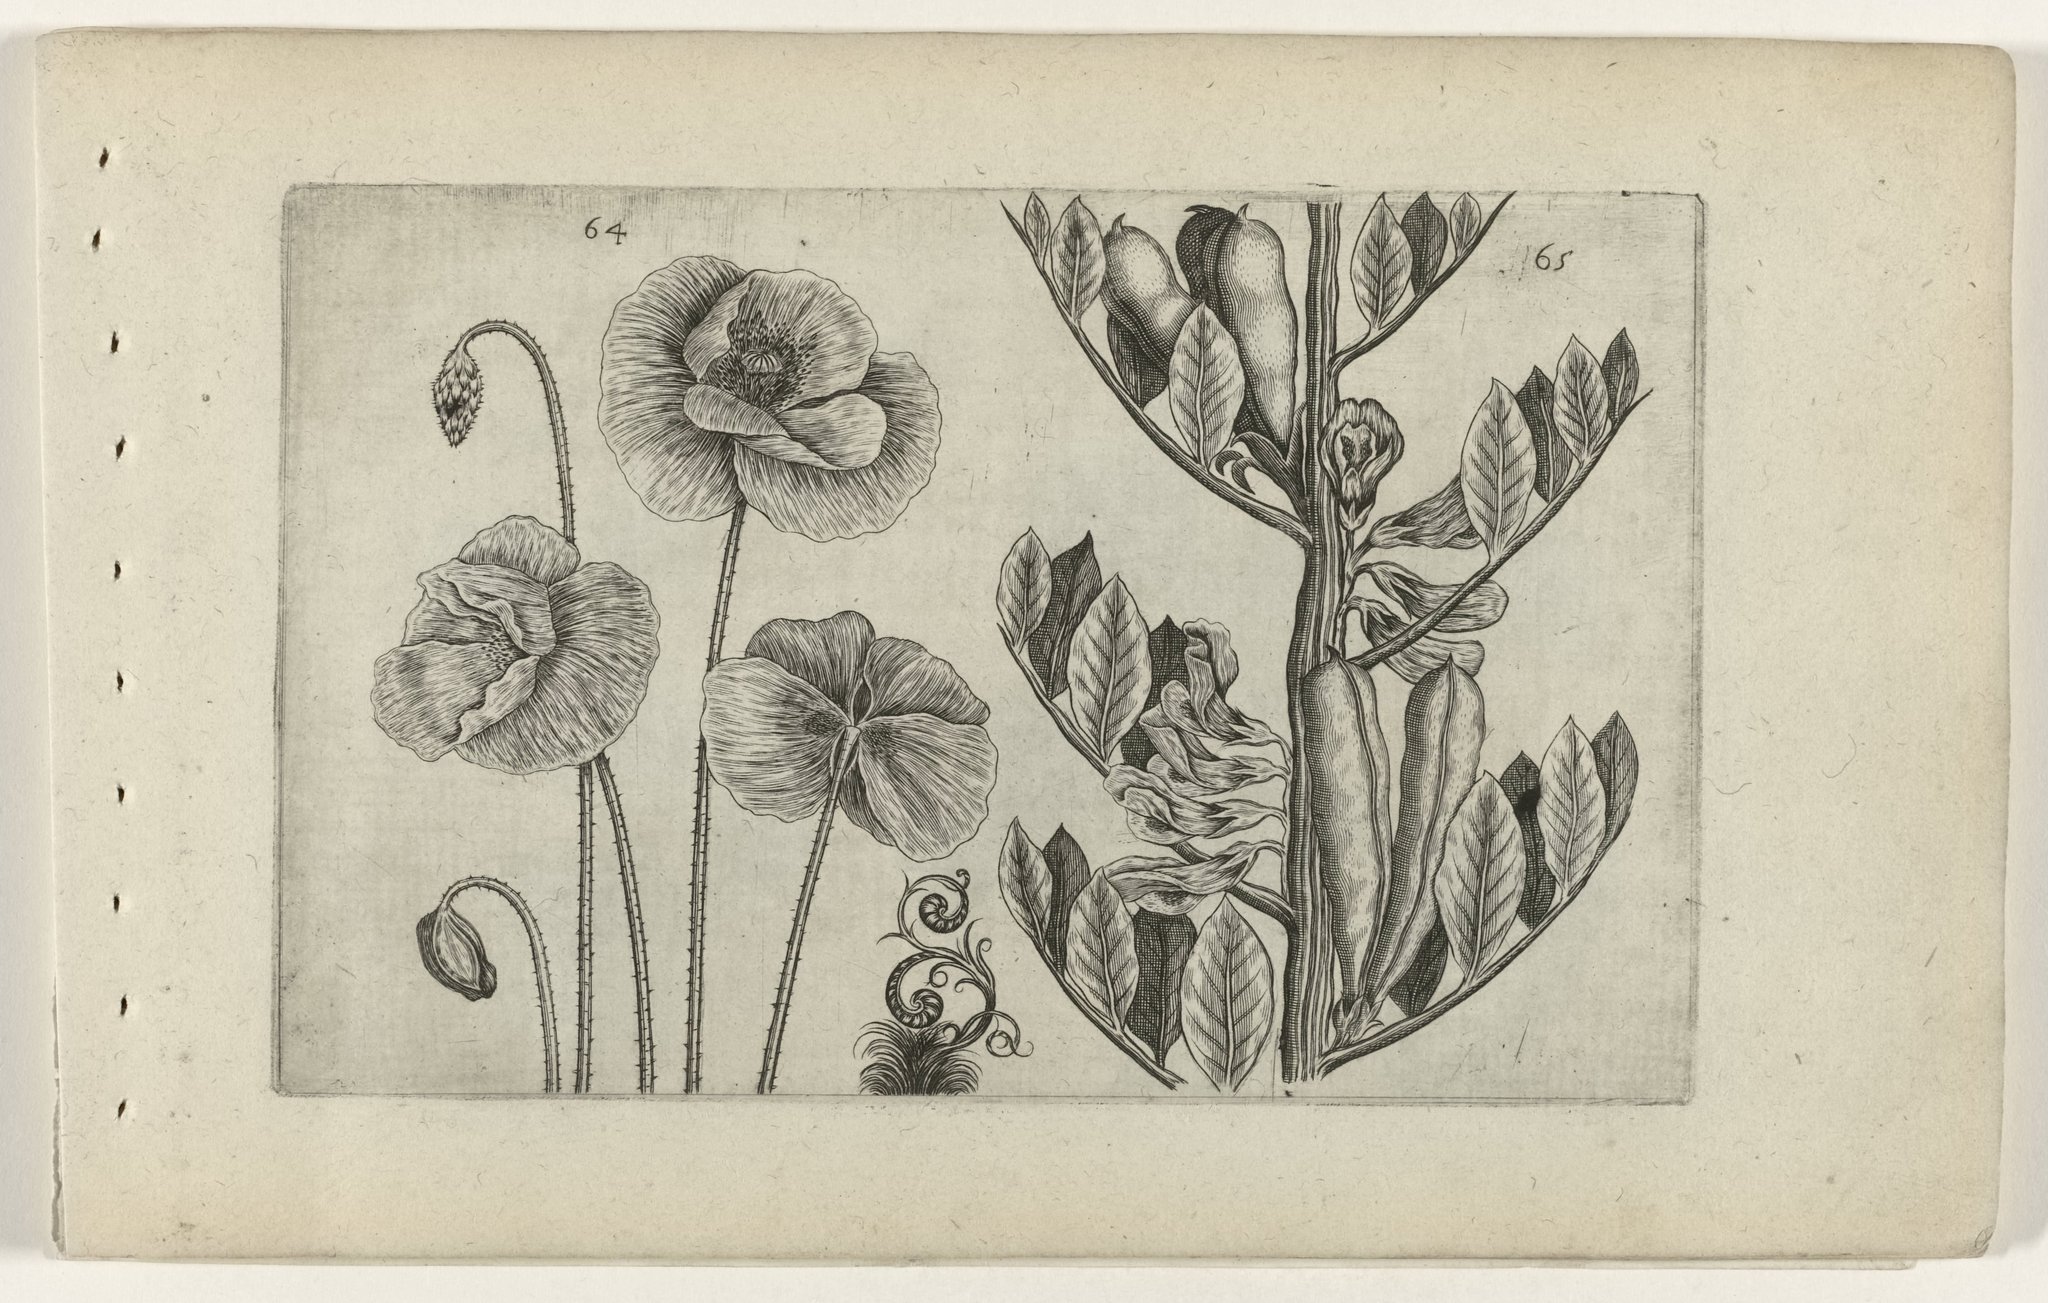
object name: album leaf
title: Grote klaproos en tuinboon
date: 1600-1604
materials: paper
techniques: engraving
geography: cologne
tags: botany, plants and herbs: bean, flowers: poppy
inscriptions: collector's mark: Lugt 2228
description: De prenten RP-P-2012-24-1 t/m 61 waren oorspronkelijk als serie samengebonden. De naaigaten op de bladen zijn nog zichtbaar. Het betreft de reeks getiteld: Cognoscite lilia, bestaande uit een titelprent en 60 gravures met 119 genummerde weergaven van planten, bloemen en vruchten, versierd met rinceaux en kleine voorstellingen van dieren. Het gaat om proefdrukken van deze reeks gravures, voor de opschriften en, deels, voor de nummering. Op enkele prenten zijn de nummers met de hand aangebracht. Op de titelprent ontbreekt nog het adres van Crispijn de Passe en Hans Woutneel. De titel is hoogstwaarschijnlijk gegraveerd door Matthias Quad. Deze werkte voor De Passe in Keulen tot 1604. De reeks moet in dit jaar of daarvoor tot stand zijn gebracht. In ieder geval voor 1608, aangezien de uitgever Hans Woutneel in of voor dat jaar overleed. In ieder geval voor 1608, aangezien de uitgever Hans Woutneel in of voor dat jaar overleed. De gravures worden door Ilja Veldman en Anthony Griffiths beschouwd als eigenhandig werk van Crispijn de Passe I. Een van de prenten uit de reeks ontbreekt (nr 21-22) en is vervangen door een ingekleurde afdruk uit een latere uitgave (RP-P-2012-24-61), die onder de titel Altera Pars is opgenomen in de Hortus Floridus, uitgegeven door Crispijn de Passe I en die verder bestaat uit platen van Crispijn de Passe II. De prenten afkomstig uit deze uitgave zijn op de verso voorzien van tekst in boekdruk. De vervangende prent maakte geen deel uit van de gebonden serie aangezien dit blad als enige geen naaigaten heeft. Een deel van de planten, bloemen en vruchten in de Cognoscite lilia gaat terug of is gebaseerd op een reeks aquarellen van Jacques LeMoyne uit circa 1580 en uit 1585, nu in het Victoria and Albert Museum en de British Museum (zie P. Hulton, Jacques LeMoyne, Londen 1977, dl 1, p. 156-162 en p. 165-173).